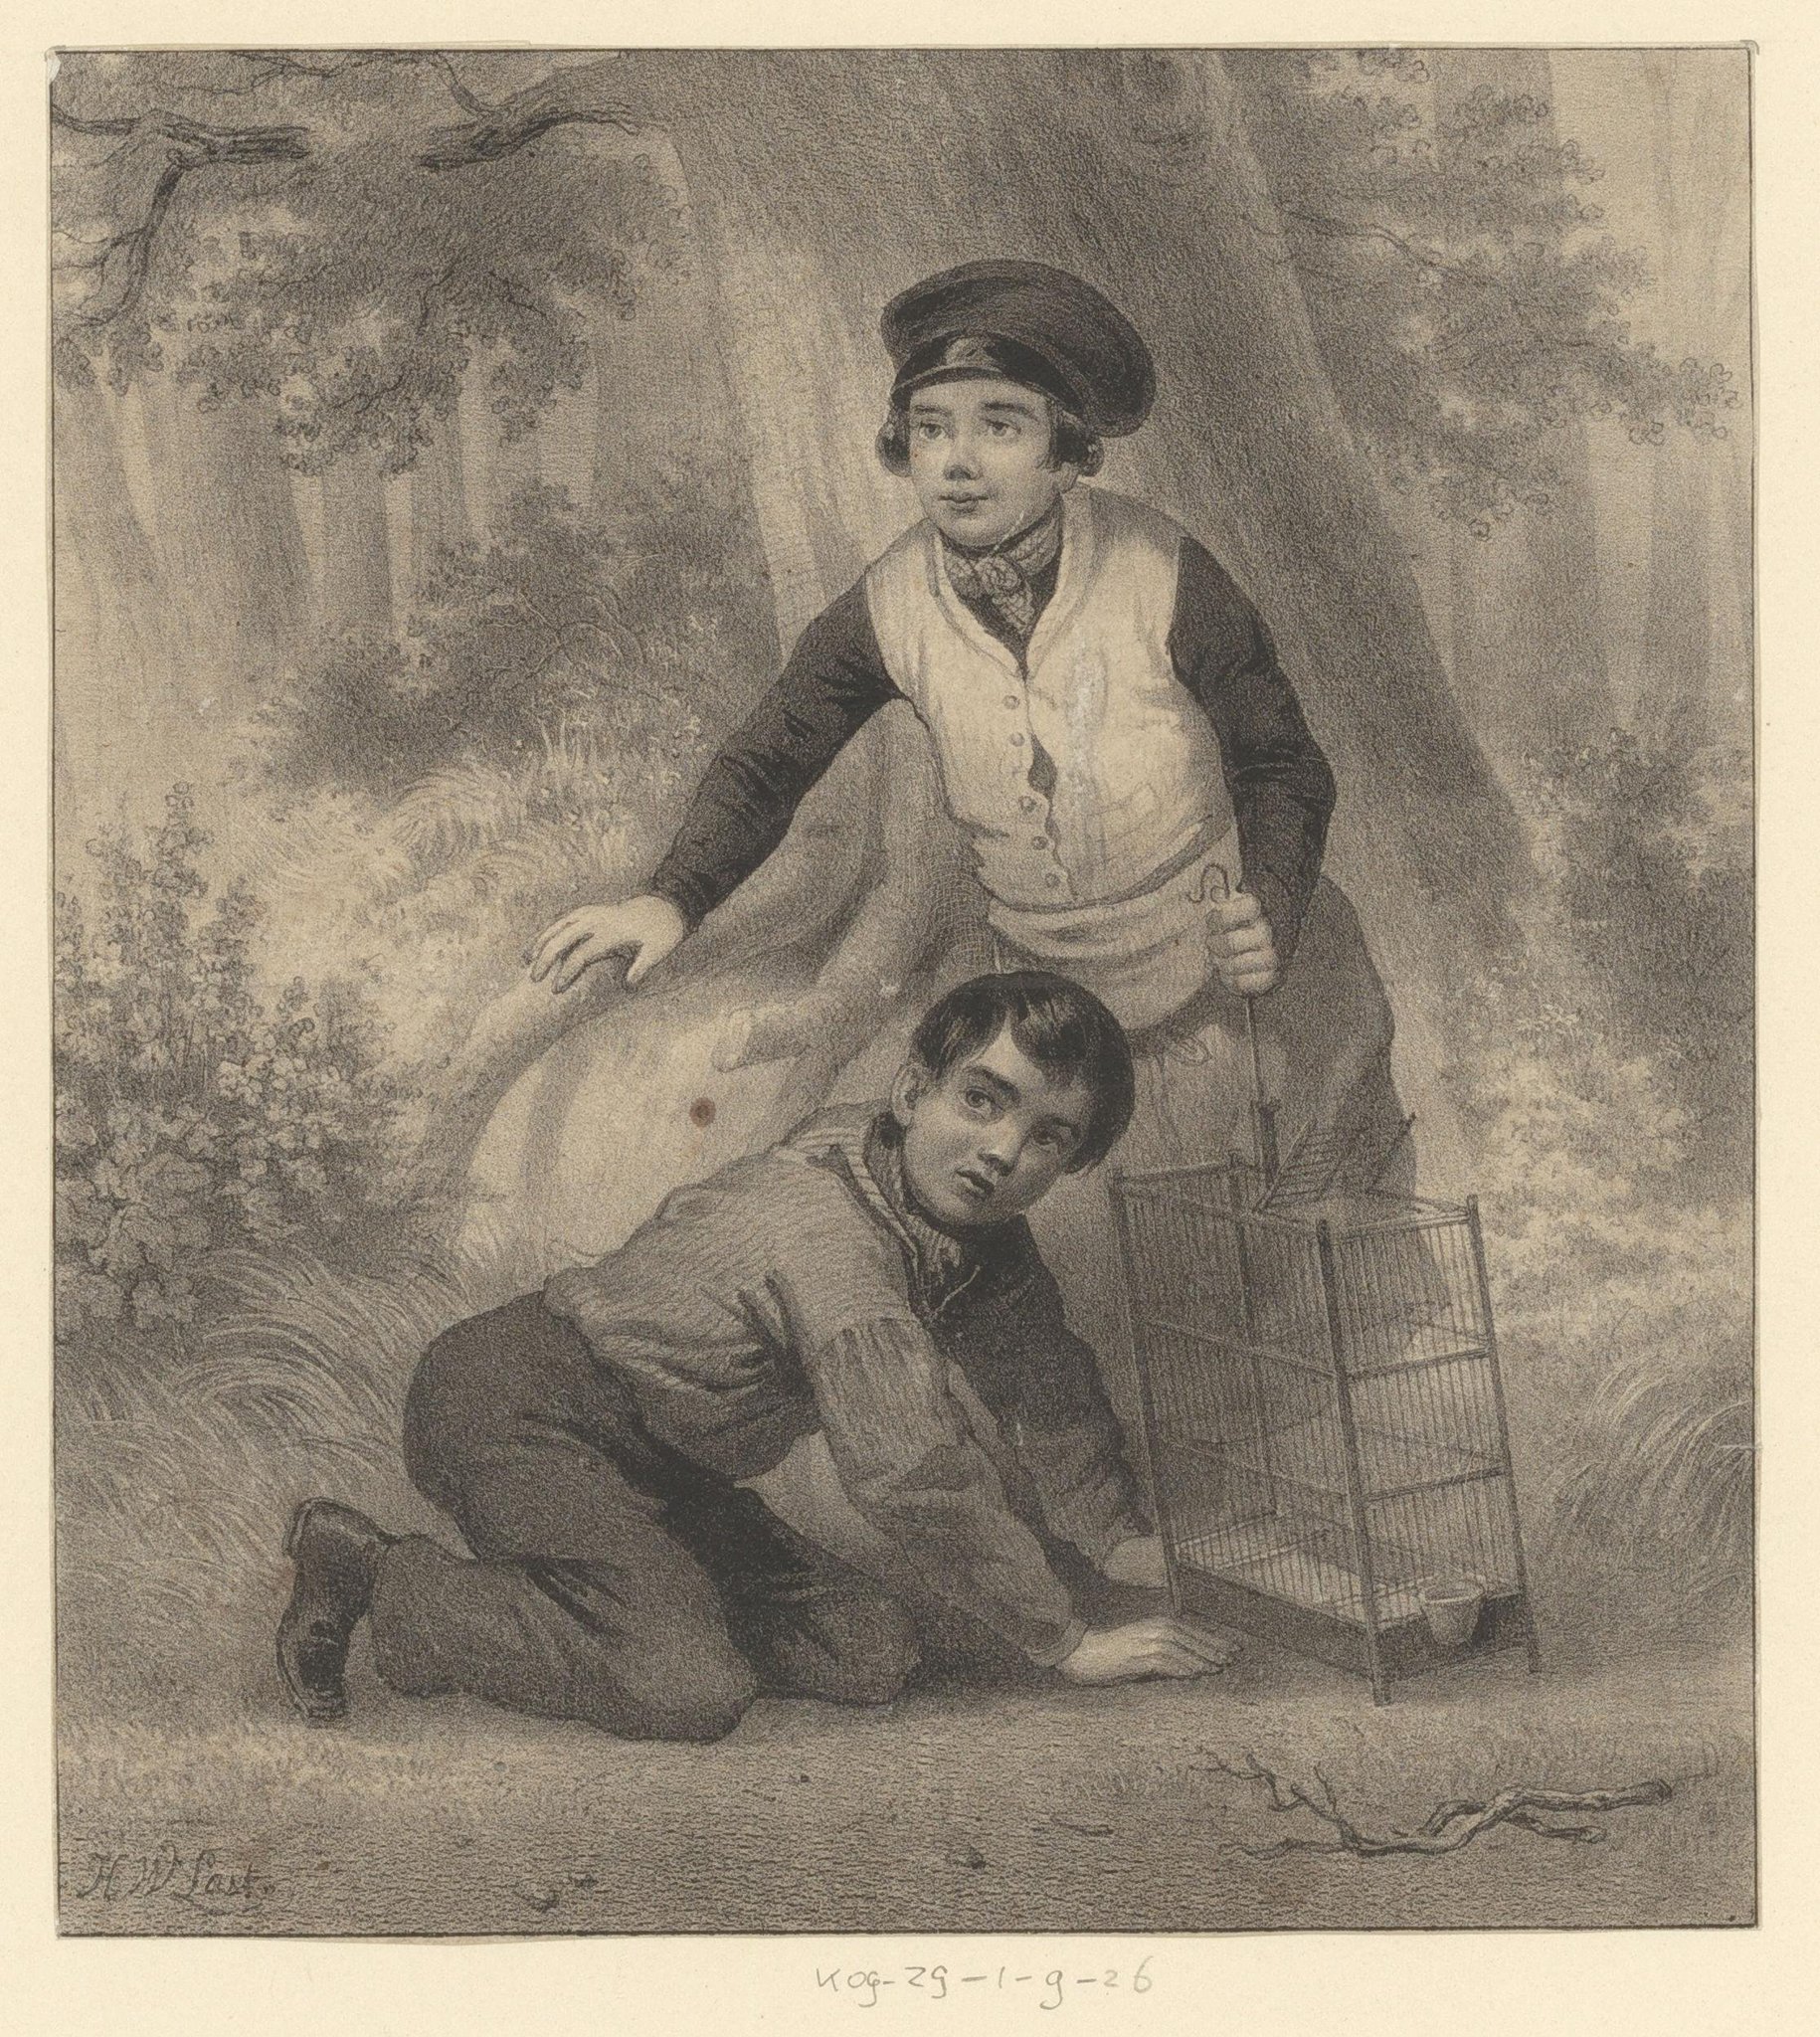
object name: print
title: Twee jongens met een vogelknip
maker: hendrik wilhelmus last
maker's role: print maker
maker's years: 1817-1873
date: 1827-1873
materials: paper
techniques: lithograph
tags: bird hunting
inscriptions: collector's mark: Lugt 1641, stamp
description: Onderwerpsrubrieken binnen de Atlas Zeden en Gewoonten: Handel, nijverheid en verkeer, jacht.